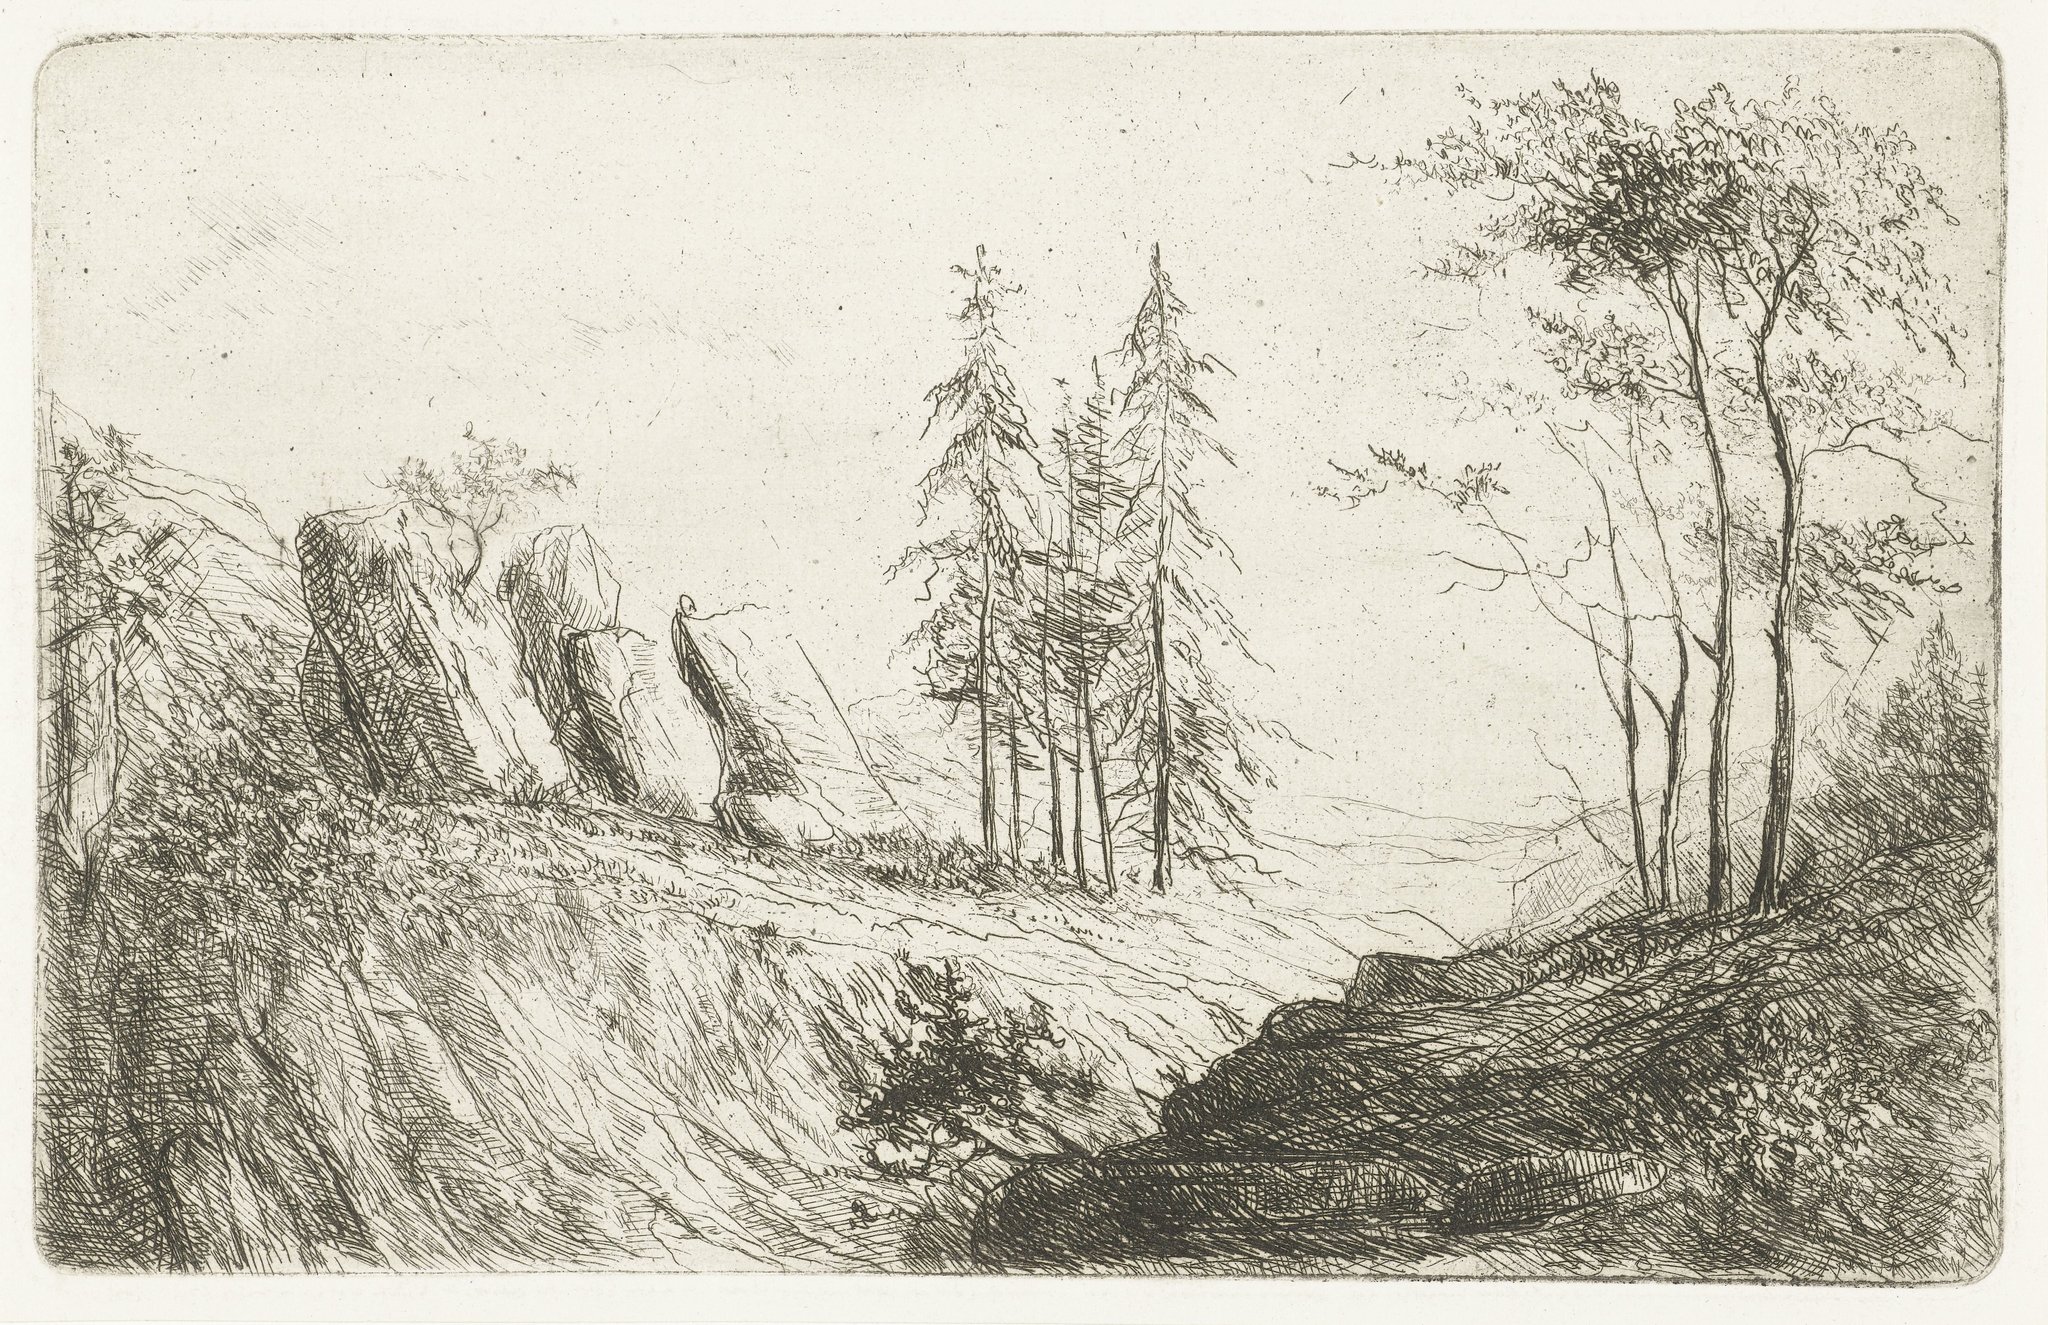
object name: print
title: Berglandschap met bomen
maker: willem matthias jan van dielen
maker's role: print maker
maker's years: 1805-1867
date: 1815-1867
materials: paper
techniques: etching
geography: netherlands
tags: mountains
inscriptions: collector's mark: Lugt 2228